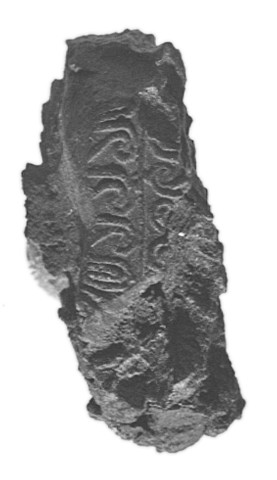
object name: sealing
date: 2030-1640 BCE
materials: clay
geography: egypt